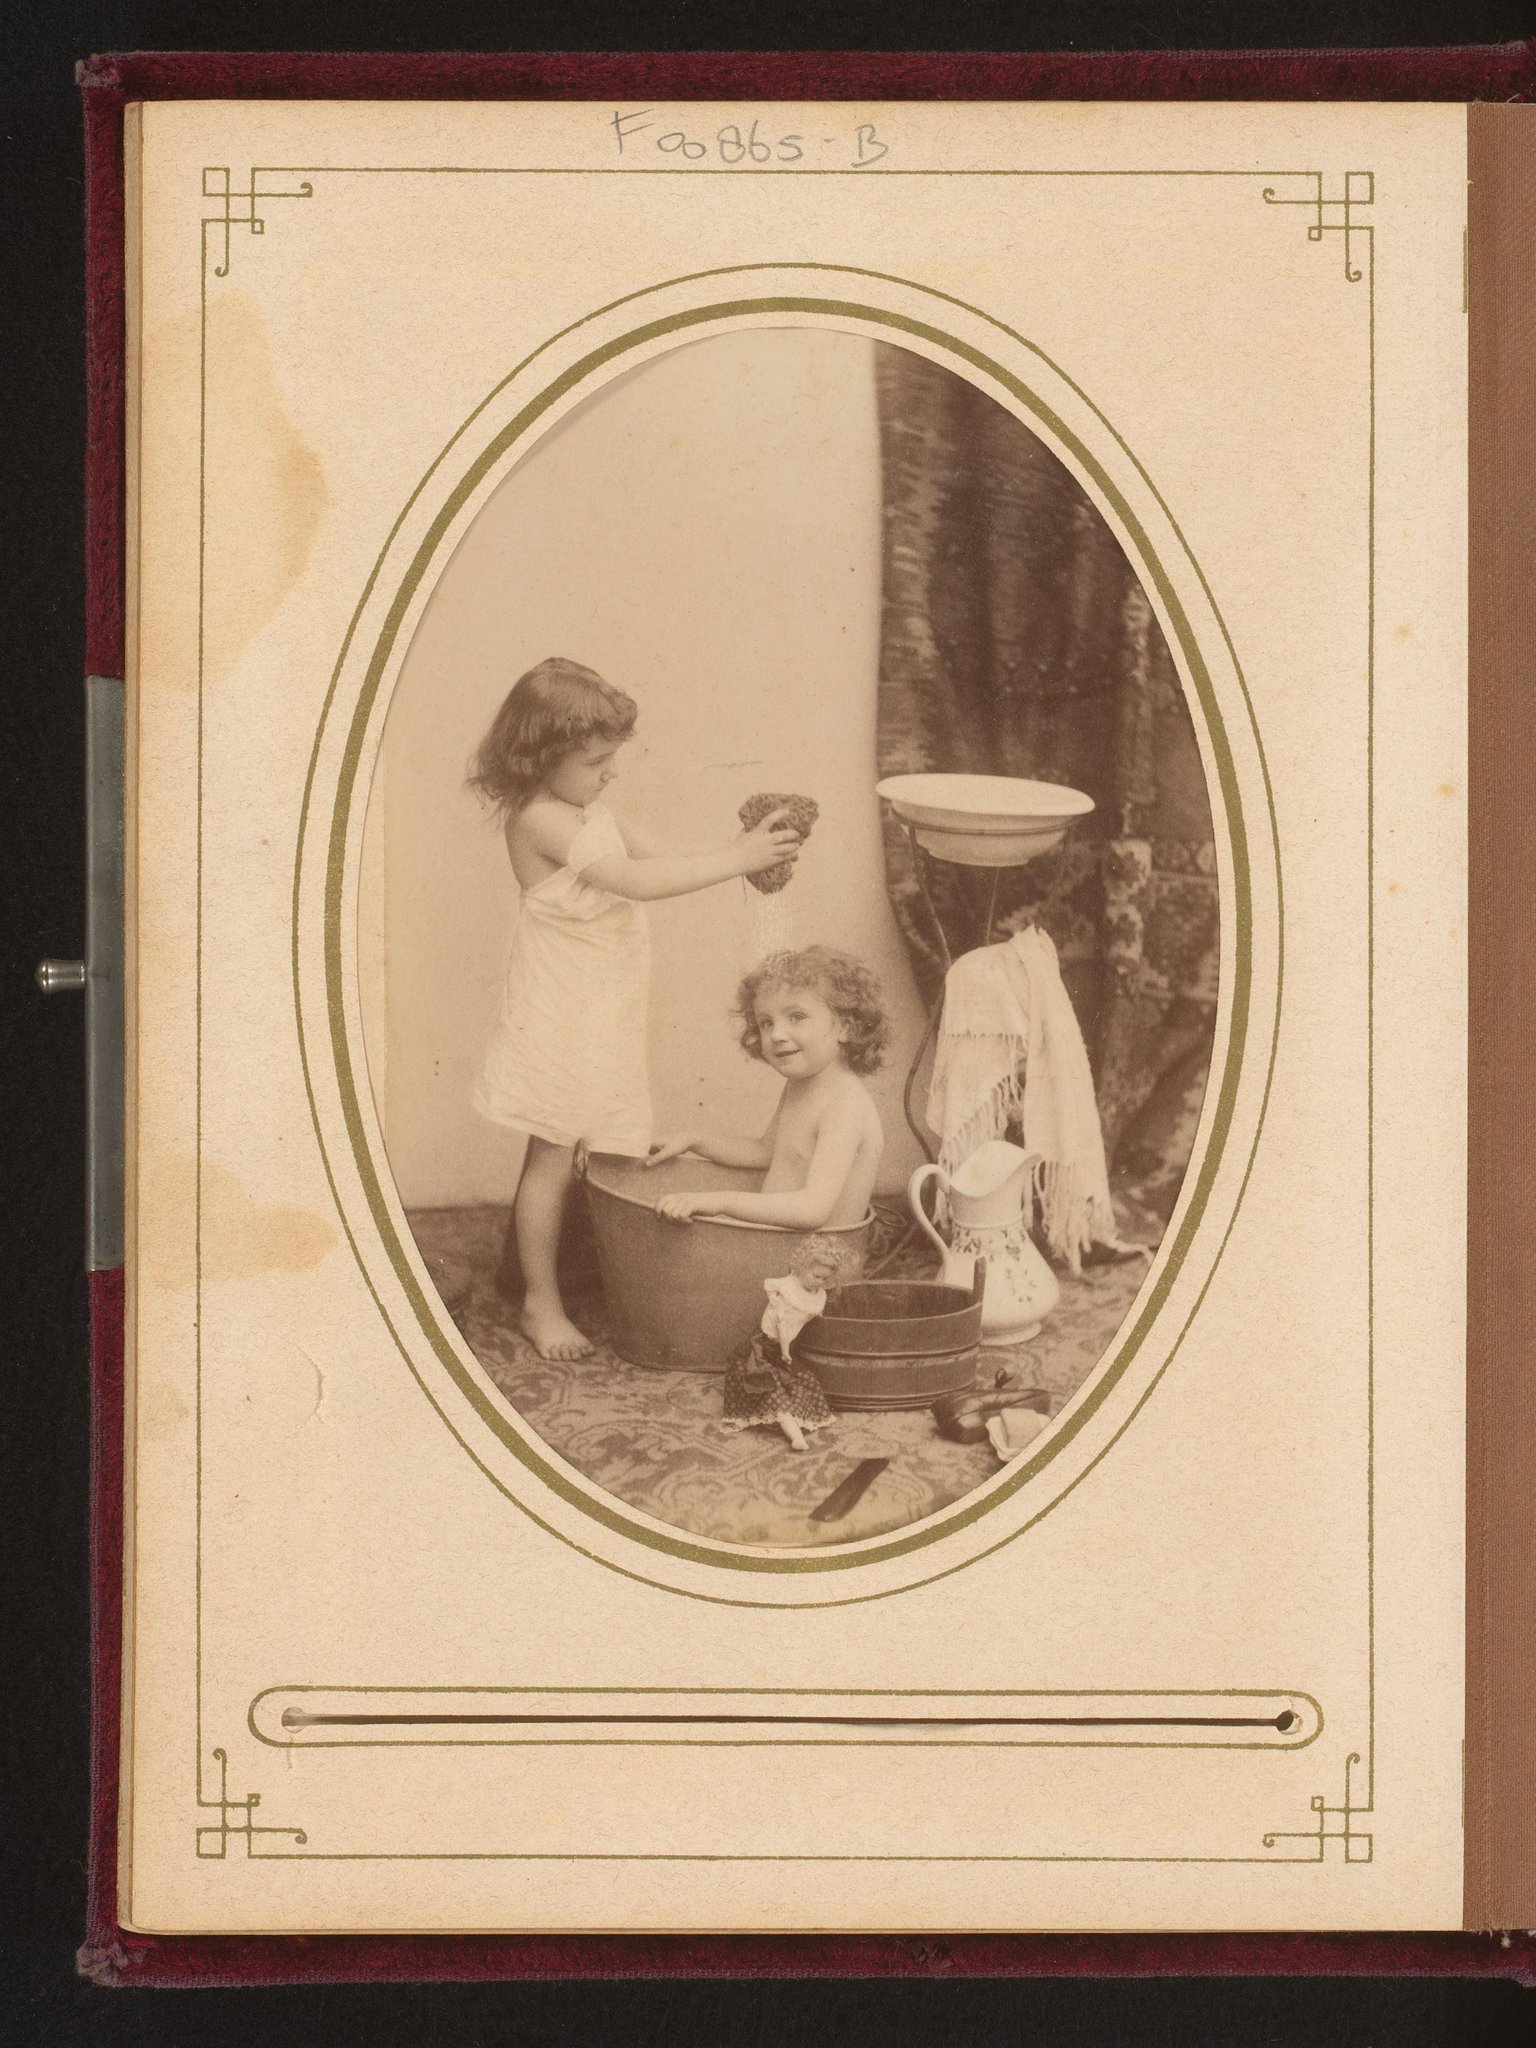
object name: album leaf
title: Kind geeft een ander kind een bad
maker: e. linde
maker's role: publisher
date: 1885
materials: cardboard, photographic support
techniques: albumen print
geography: berlin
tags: tub-bath, child (+ two persons)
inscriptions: inscription: ‘No. 174 Das Kinder Bad. - Bain des Enfants./ BERLIN W. 1885. E. LINDE Kunstverlag.’, number: ‘82,00’